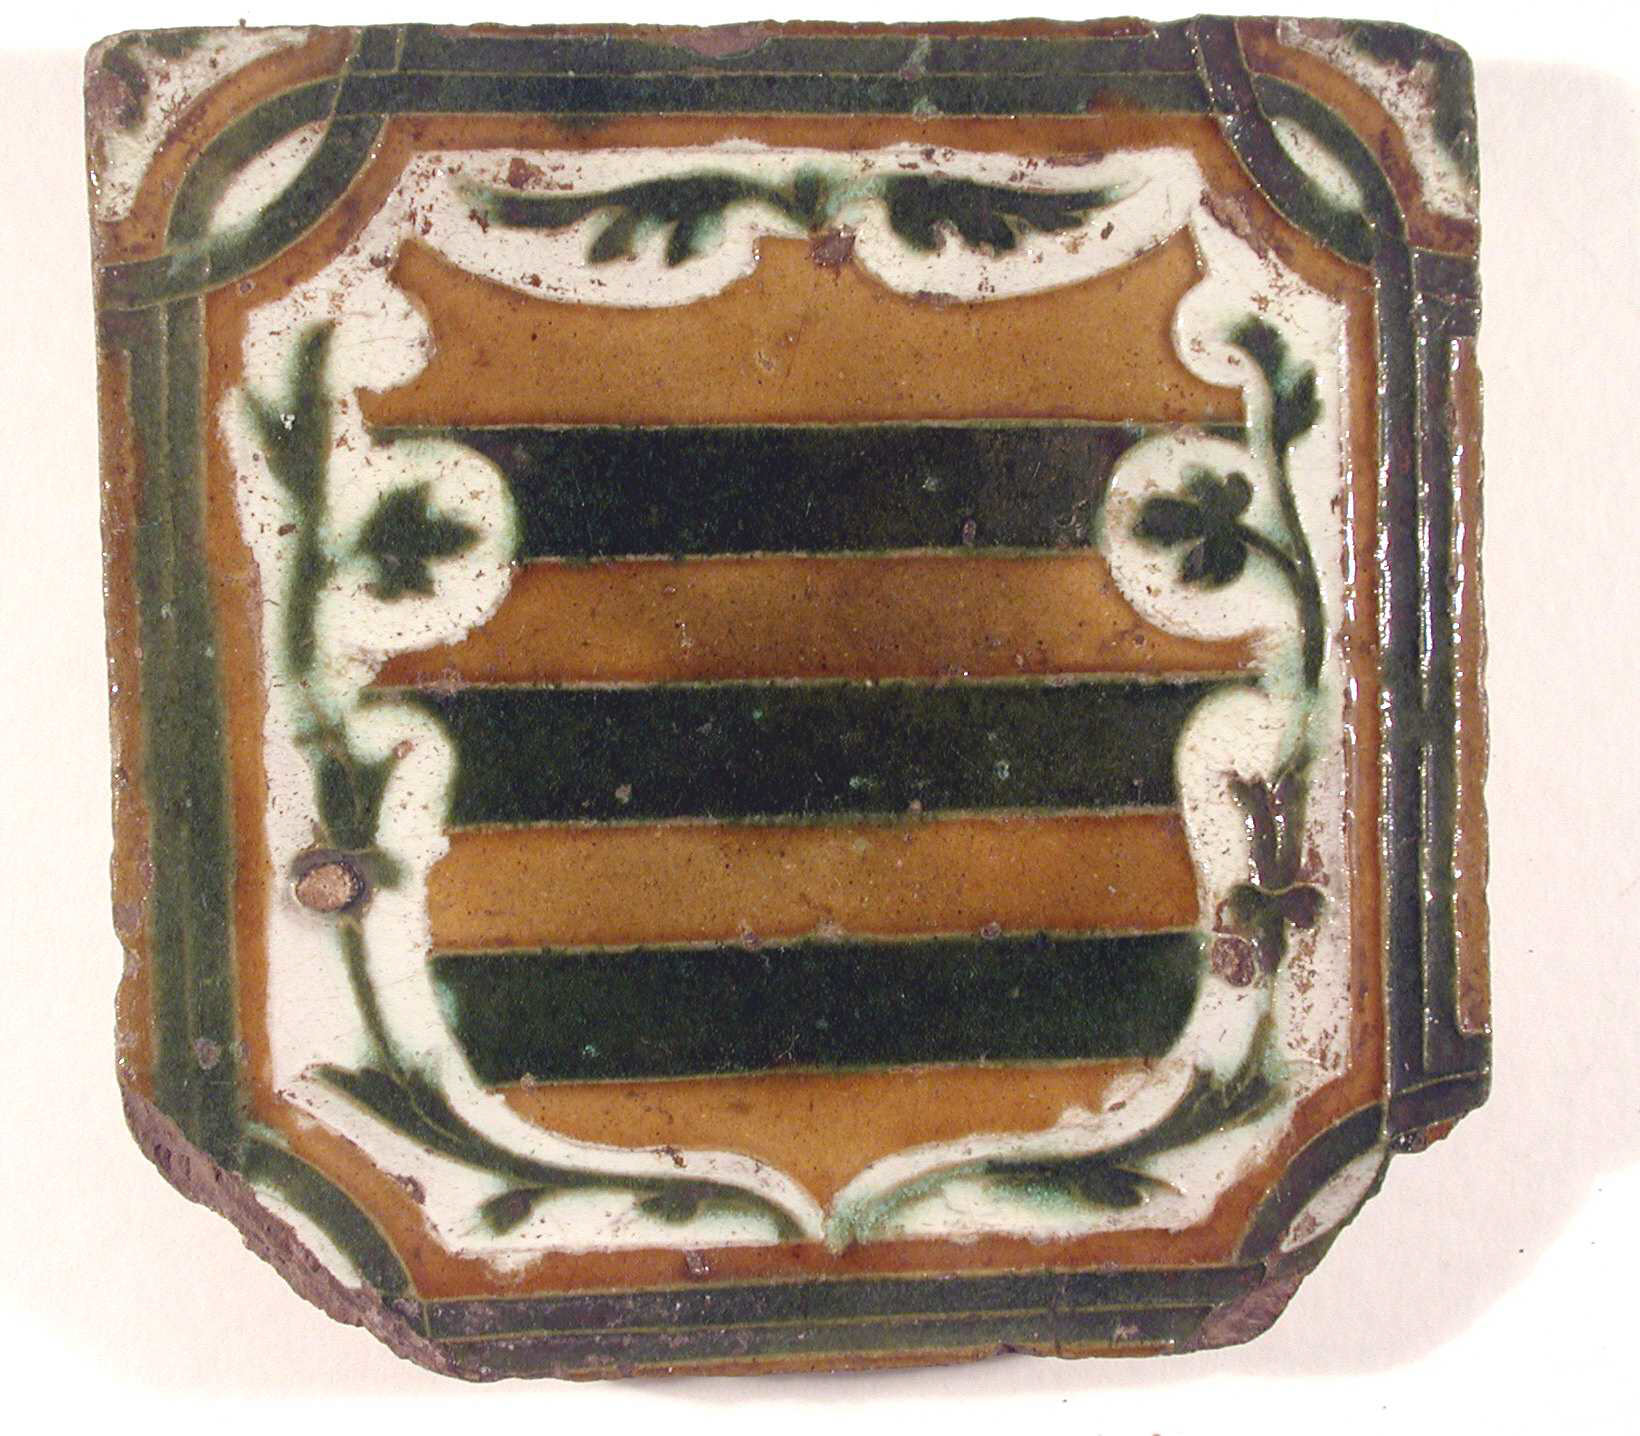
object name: wall tile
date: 1501-1600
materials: earthenware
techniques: luster painting, glazing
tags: leaves